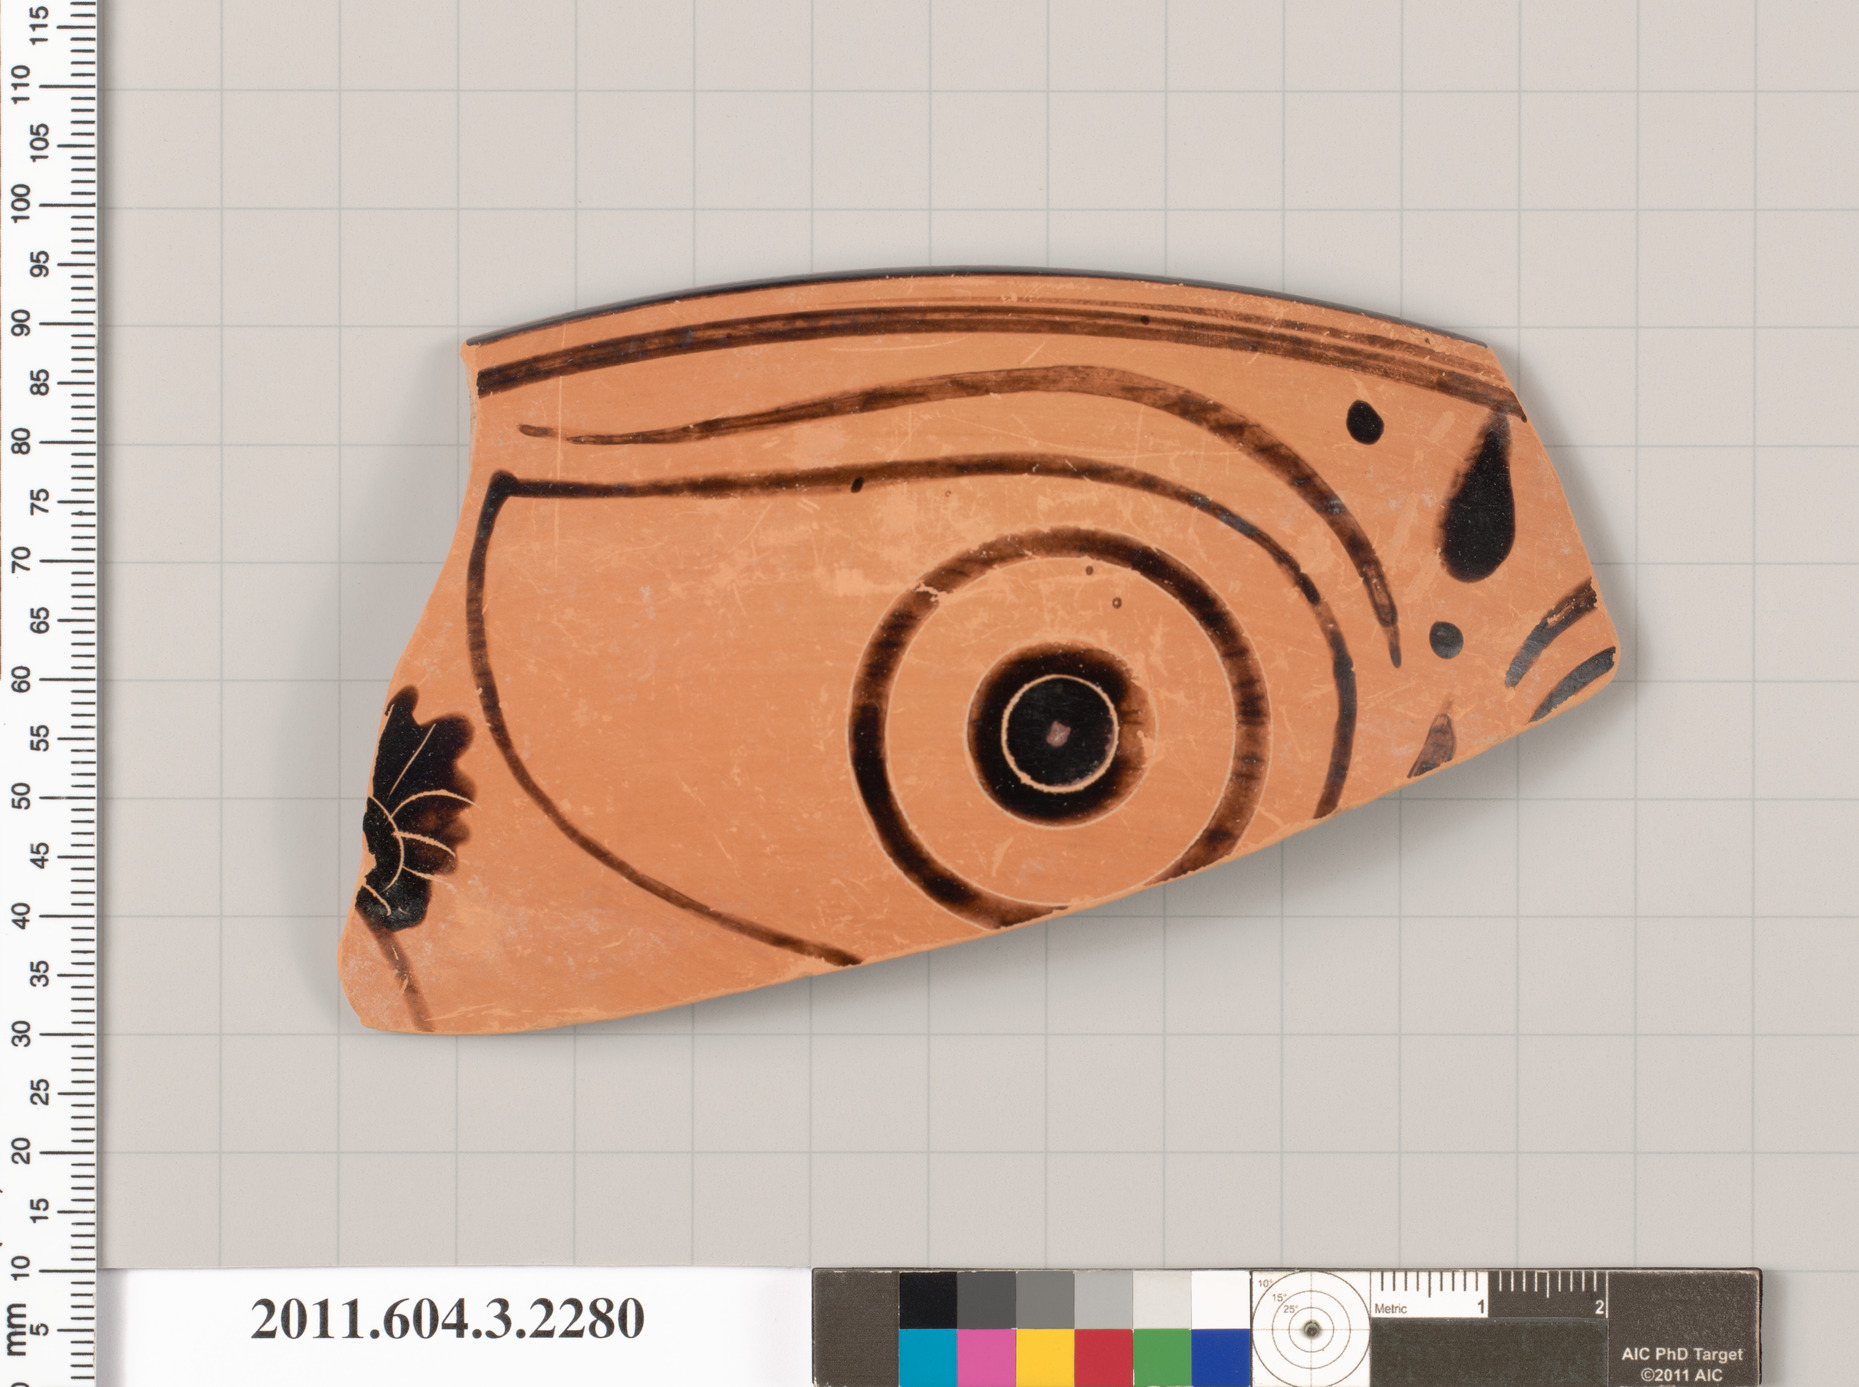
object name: kylix fragment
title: Terracotta rim fragment of a kylix: eye-cup (drinking cup)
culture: greek, attic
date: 520-510 BCE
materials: terracotta